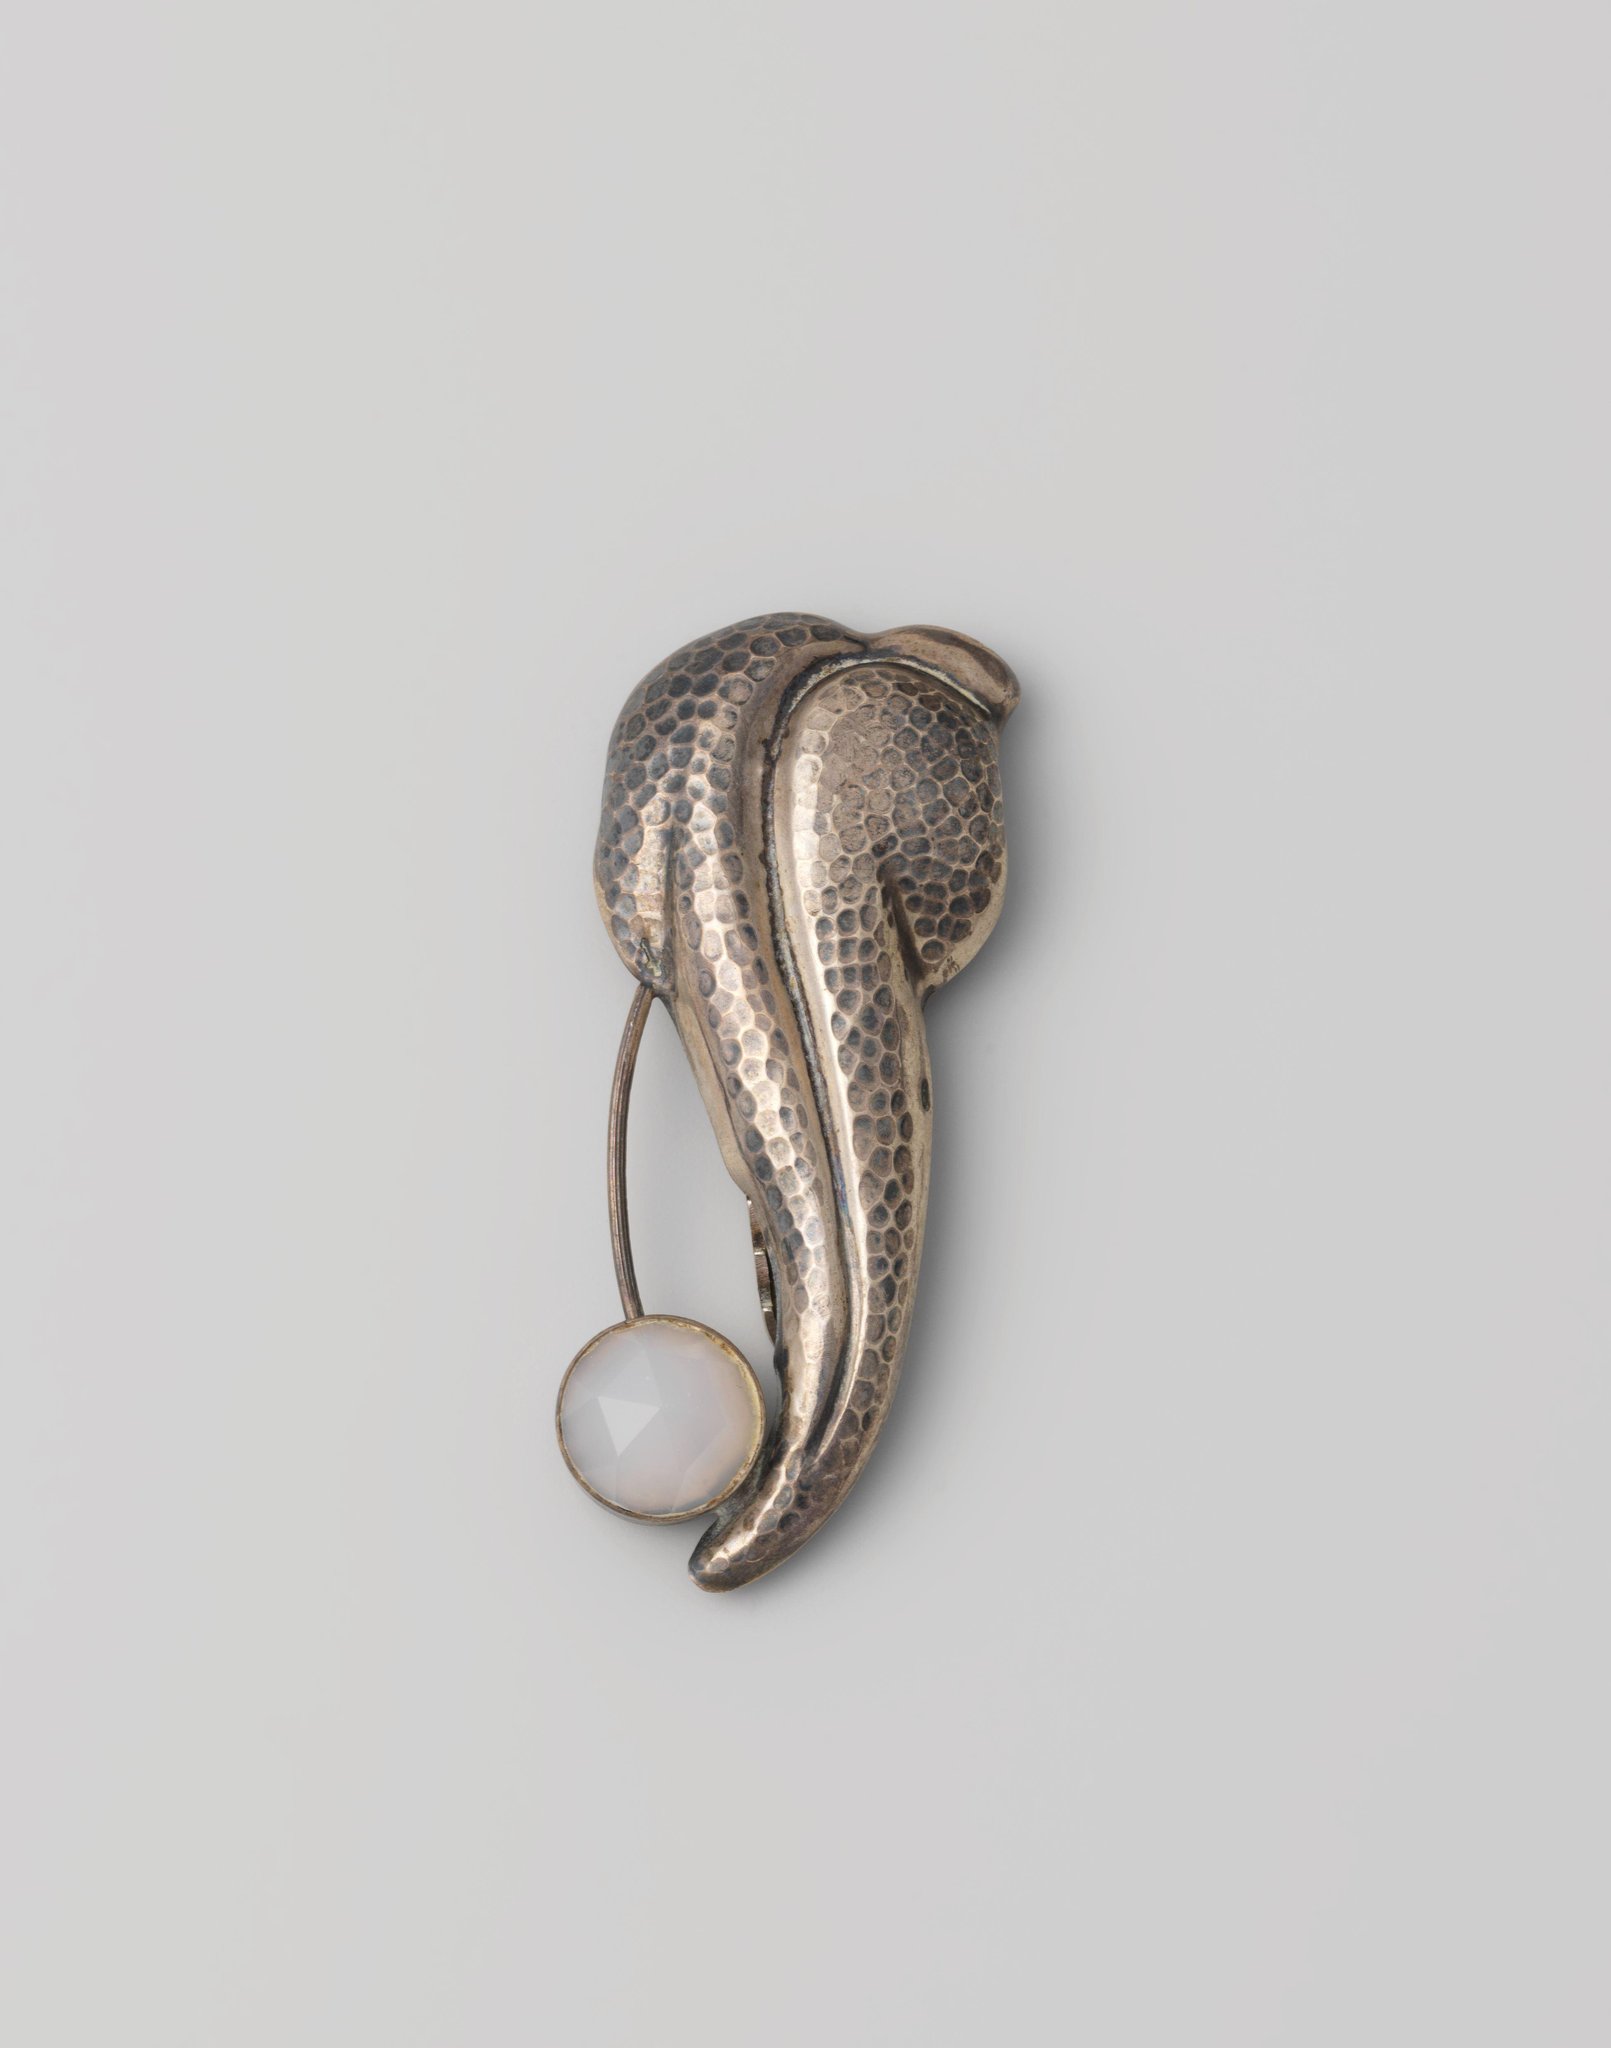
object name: clip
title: Clip van zilver, 'Aronskelk' met gefacetteerde melkwitte chalcedoon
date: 1935-1936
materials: stone, silver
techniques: faceting, hammering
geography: schoonhoven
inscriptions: maker's mark: ‘DG’, alloy mark: ‘(oud) zwaard’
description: Gehamerde clip van zilver, 'Aronskelk', met gefacetteerde melkwitte chalcedoon.